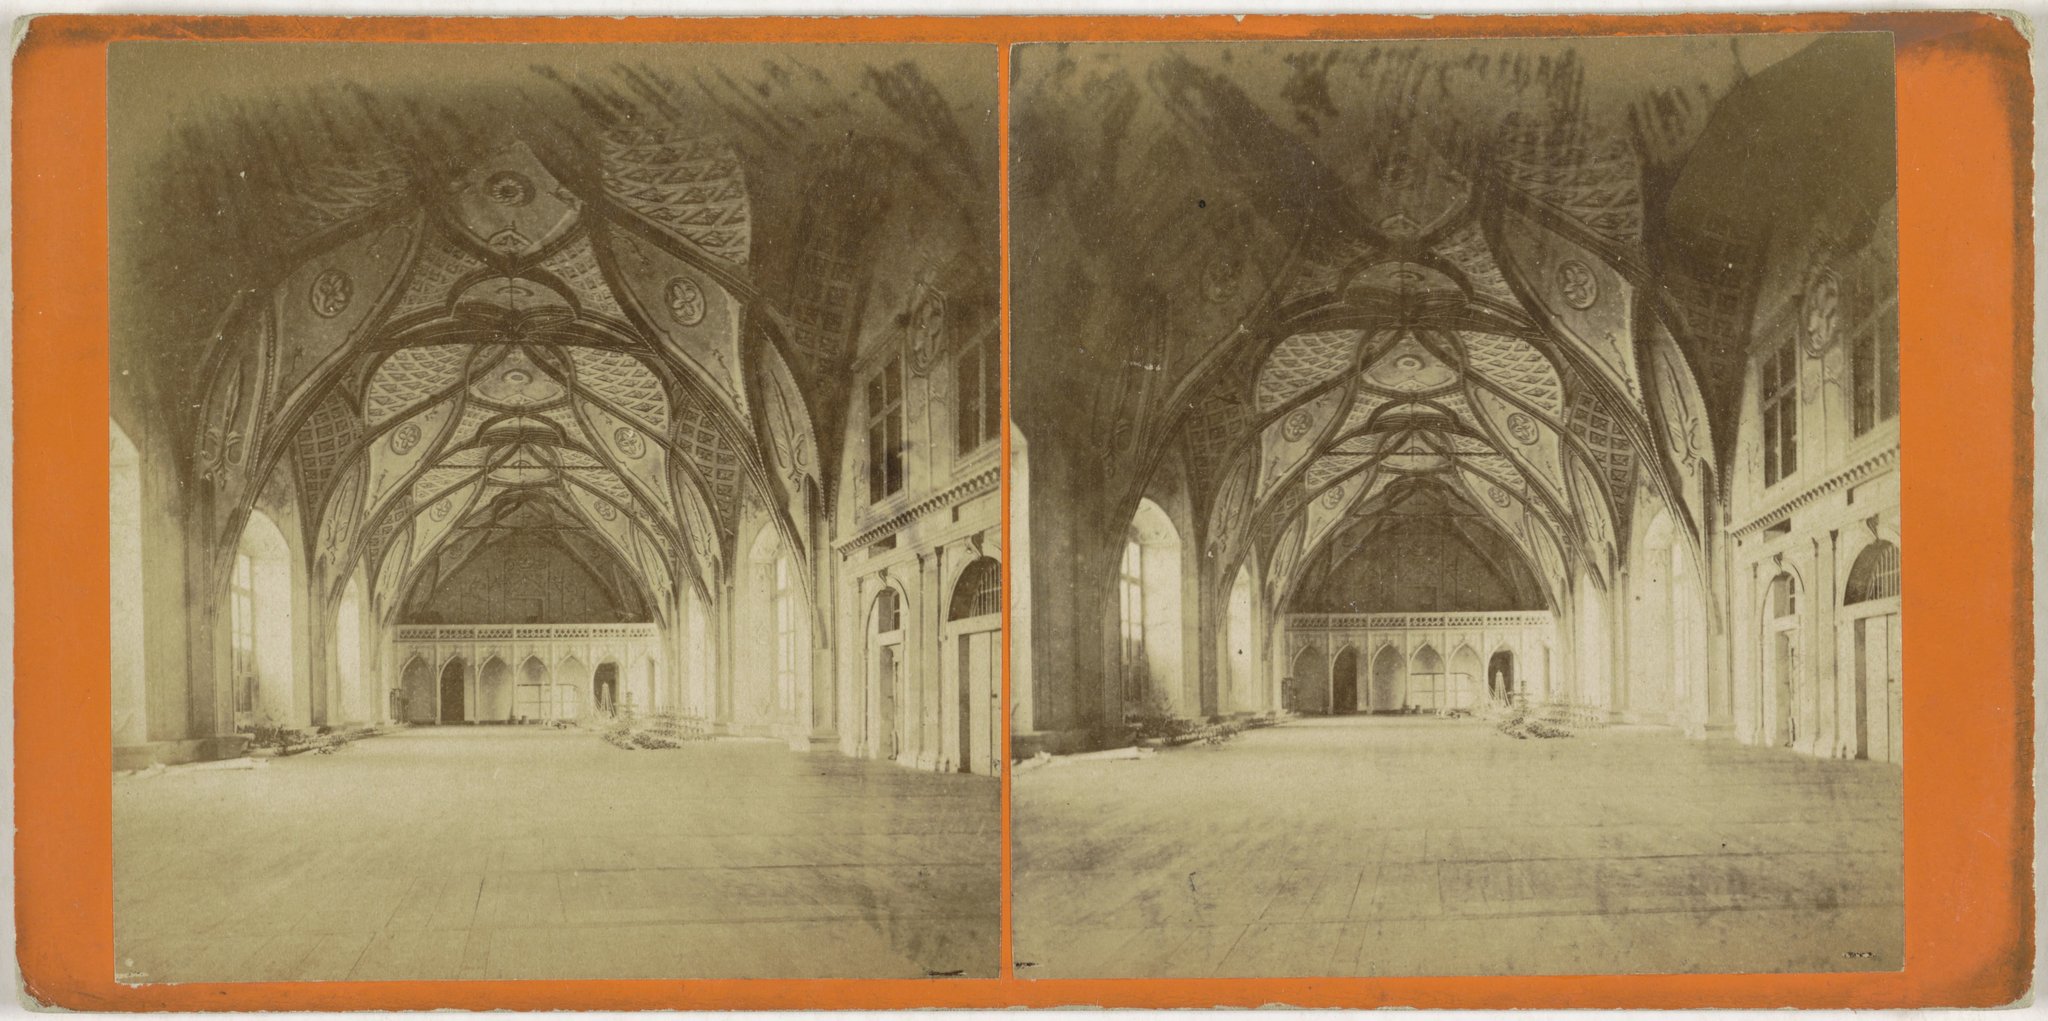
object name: stereograph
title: Wladislaw'scher (Krönungssaal) in der k. Burg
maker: františek fridrich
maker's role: publisher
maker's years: 1829-1892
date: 1855-1868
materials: cardboard, paper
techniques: albumen print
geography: prague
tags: palace, throne-room, prague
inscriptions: inscription: ‘K. Preuss. Hoflieferant’, number: ‘150’